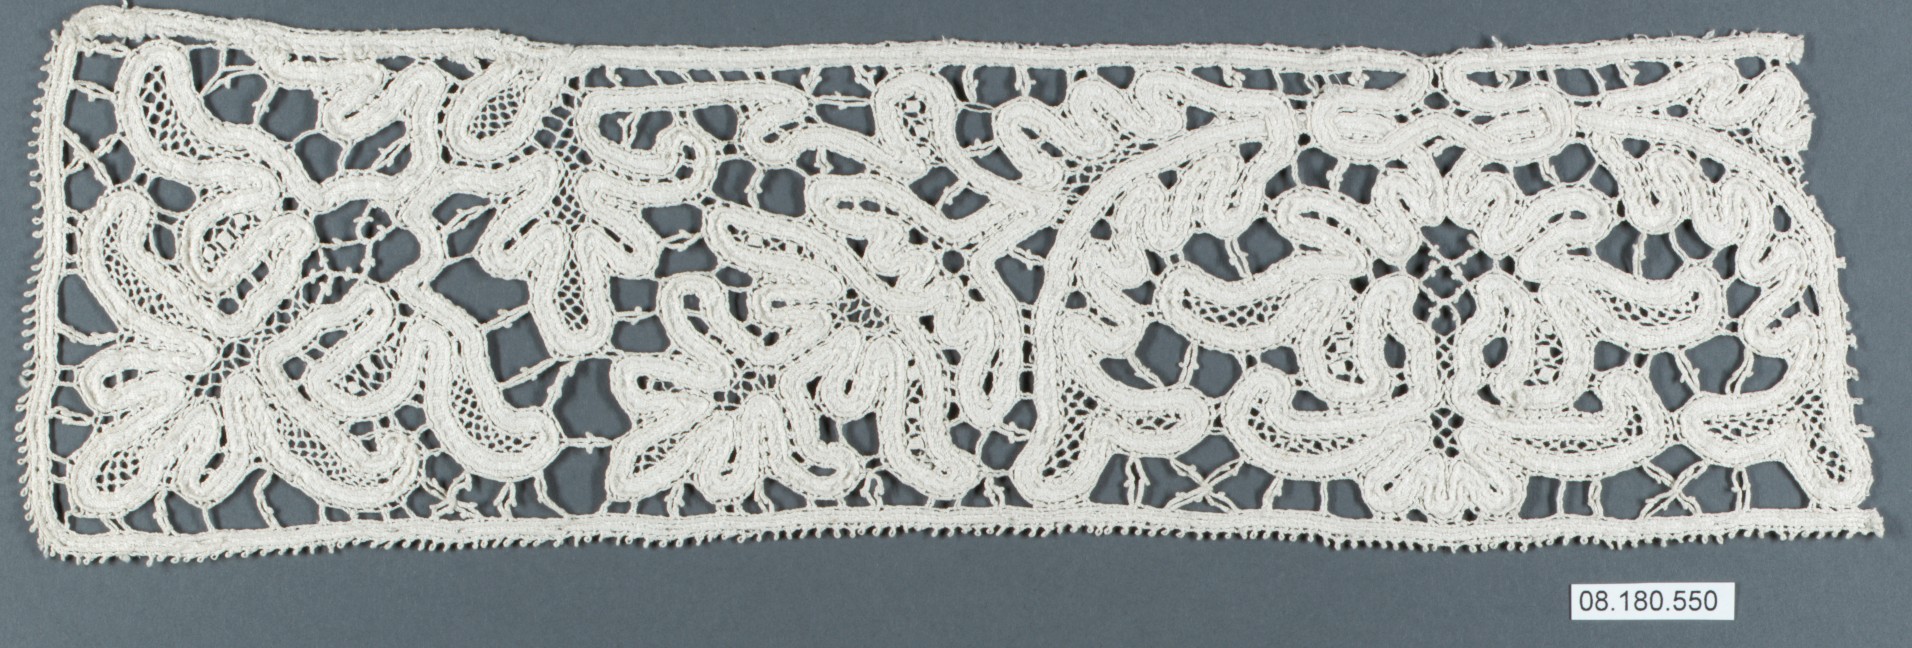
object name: fragment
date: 1701-1800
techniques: lace